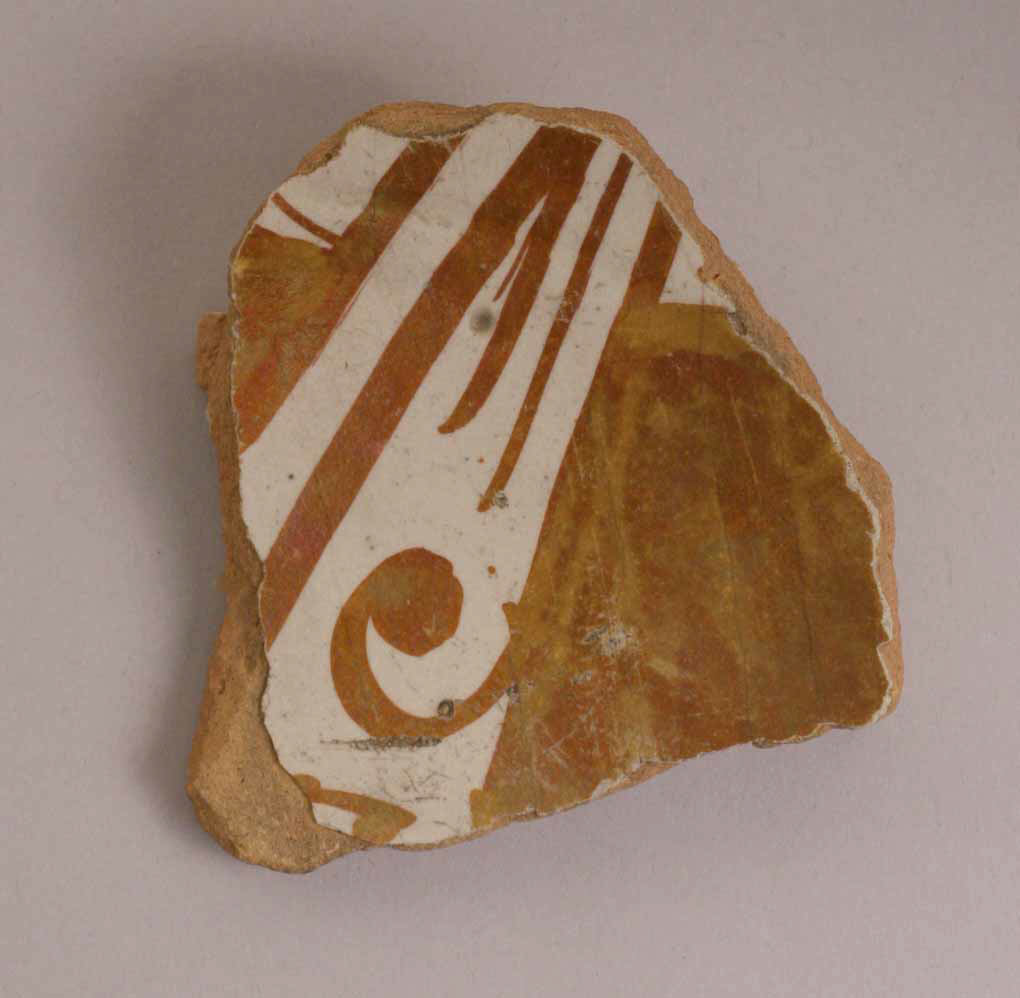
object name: ceramic fragment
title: Fragment of a Dish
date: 1001-1200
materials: earthenware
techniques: luster painting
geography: egypt